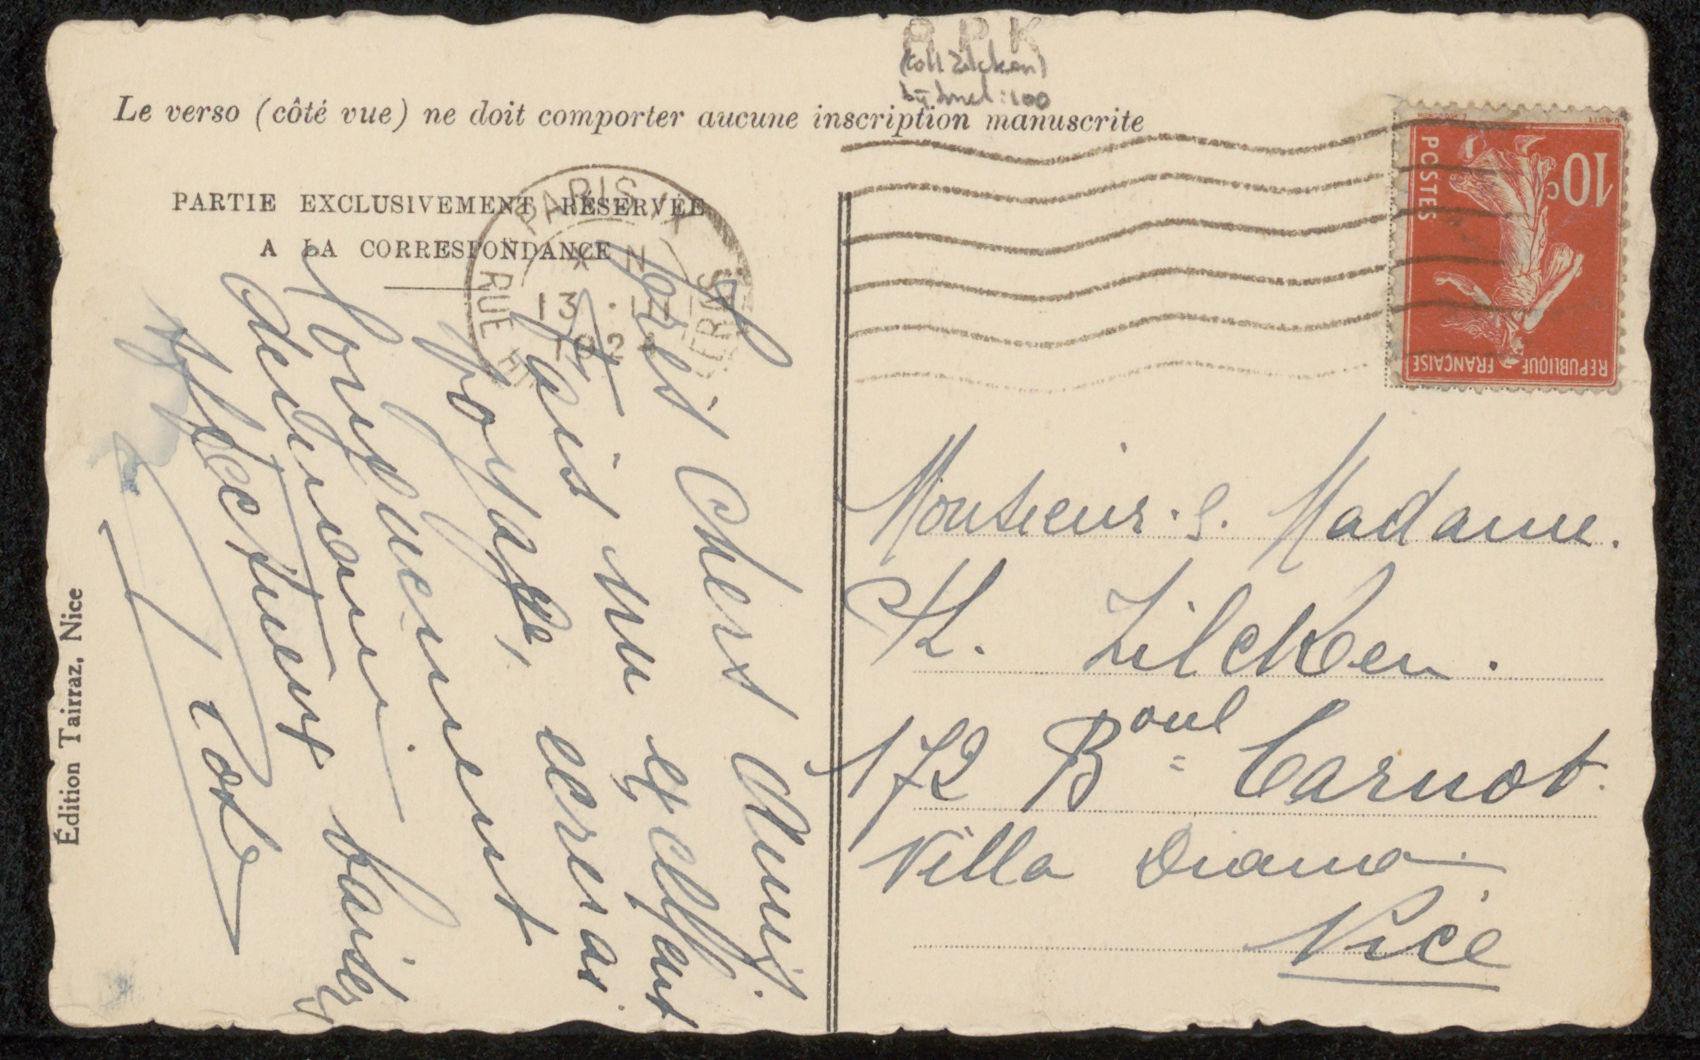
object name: ansichtkaart, prentbriefkaart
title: Prentbriefkaart aan Philip Zilcken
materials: cardboard, ink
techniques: photograph, pen, writing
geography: nice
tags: the hague, painter, draughtsman, philip zilcken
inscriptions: collector's mark: ‘RPK’